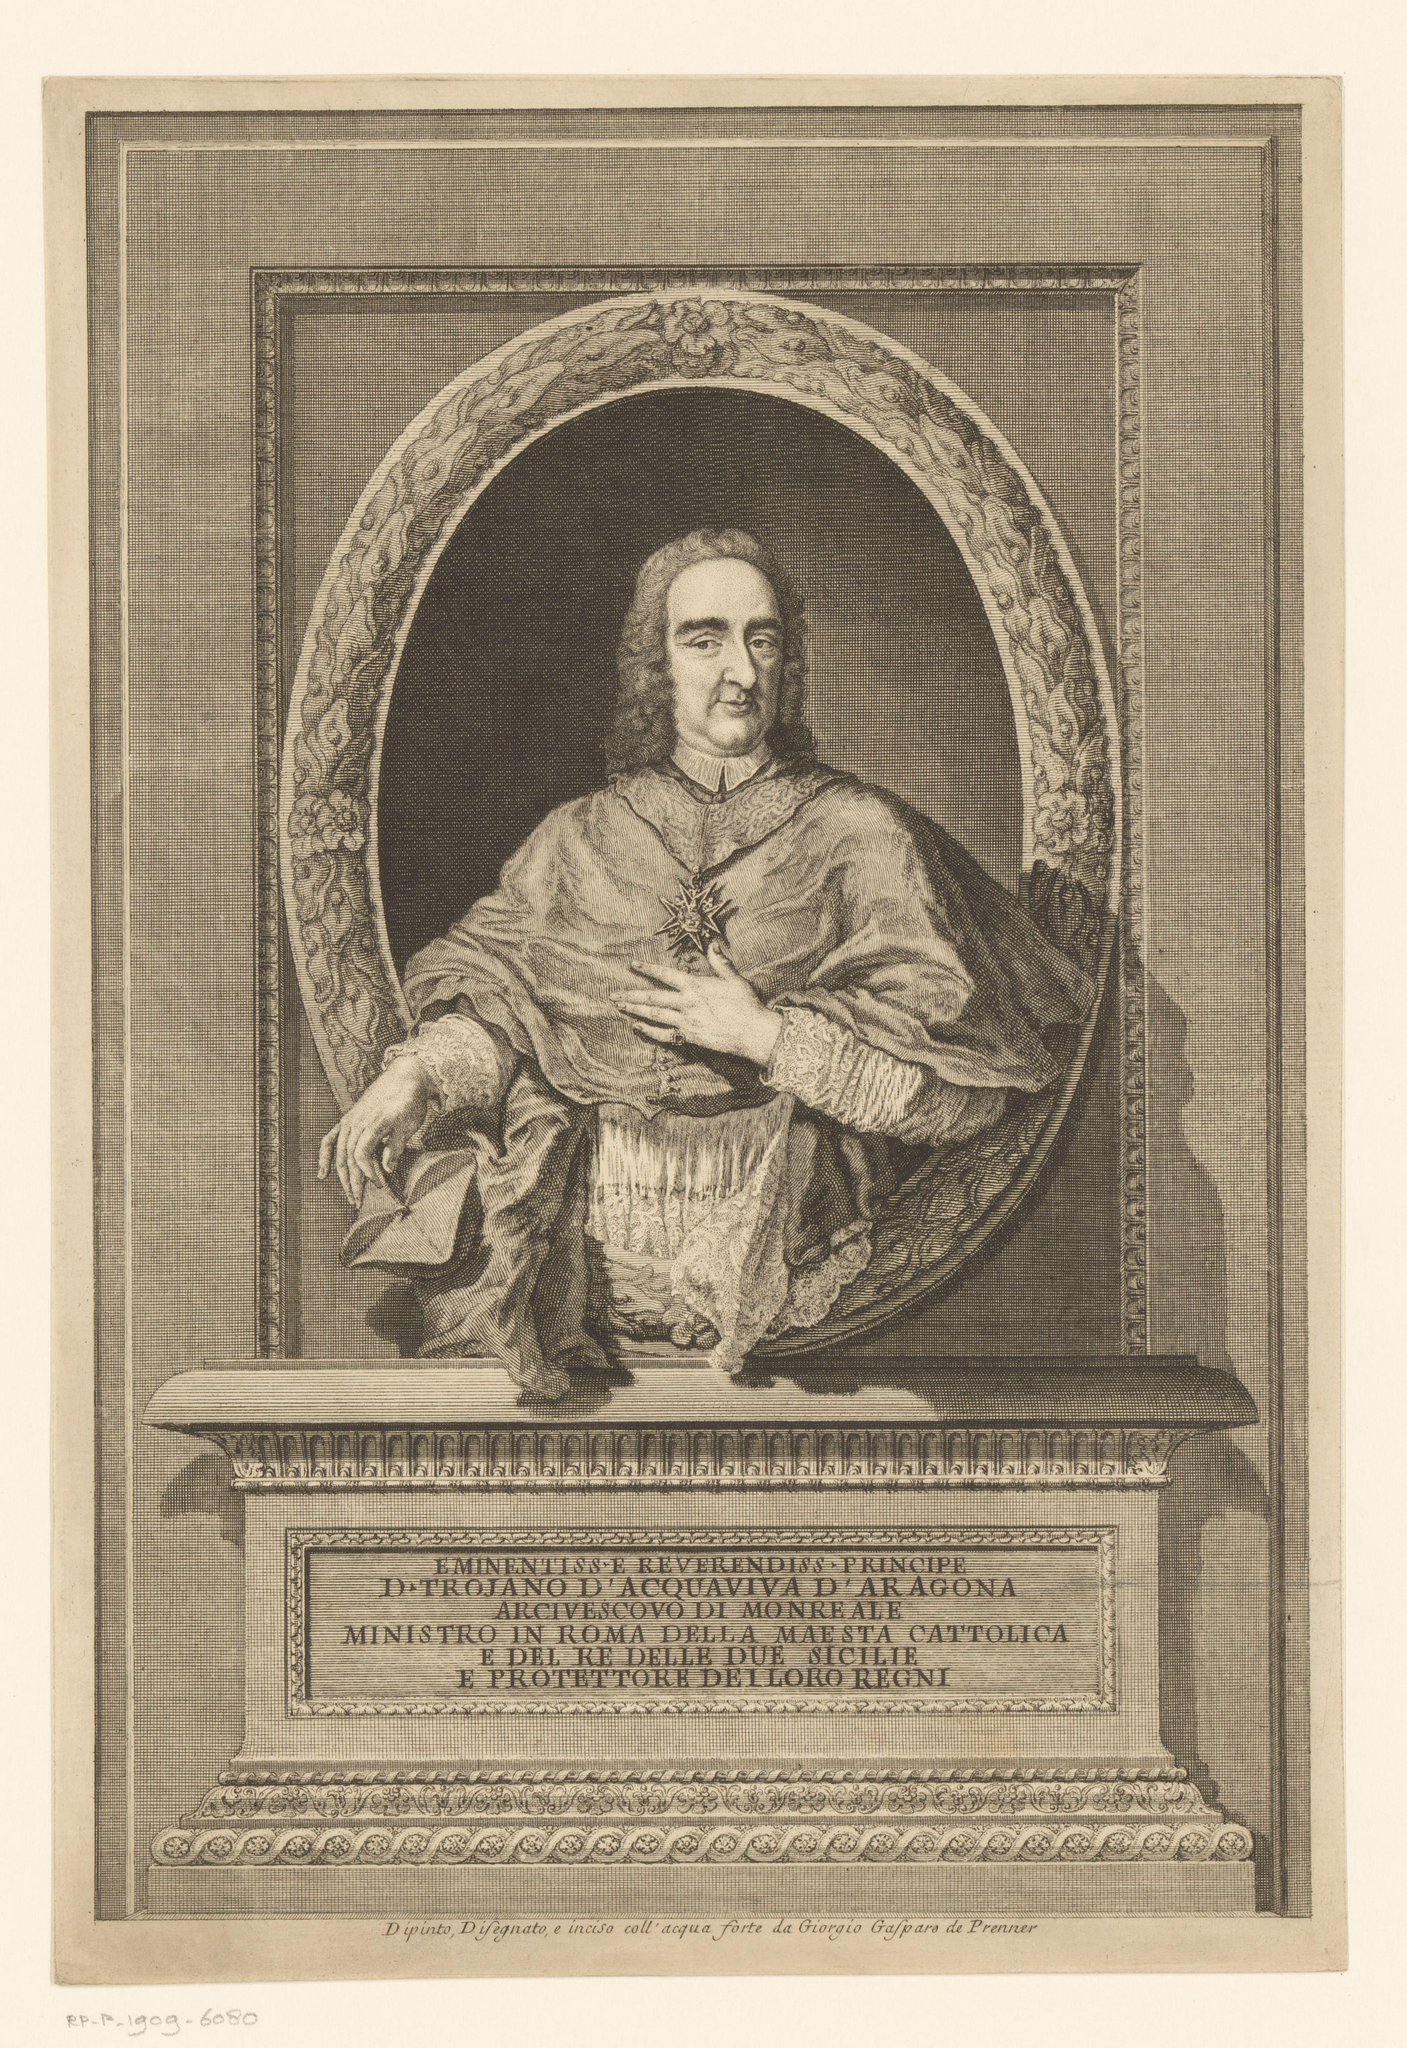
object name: print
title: Portret van Troiano Acquaviva d’Aragona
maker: georg kaspar von prenner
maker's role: print maker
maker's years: 1720-1766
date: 1732-1766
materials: paper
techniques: engraving, etching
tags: naples, rome, priest, theologian, medals and other marks of military honour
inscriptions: collector's mark: Lugt 2228